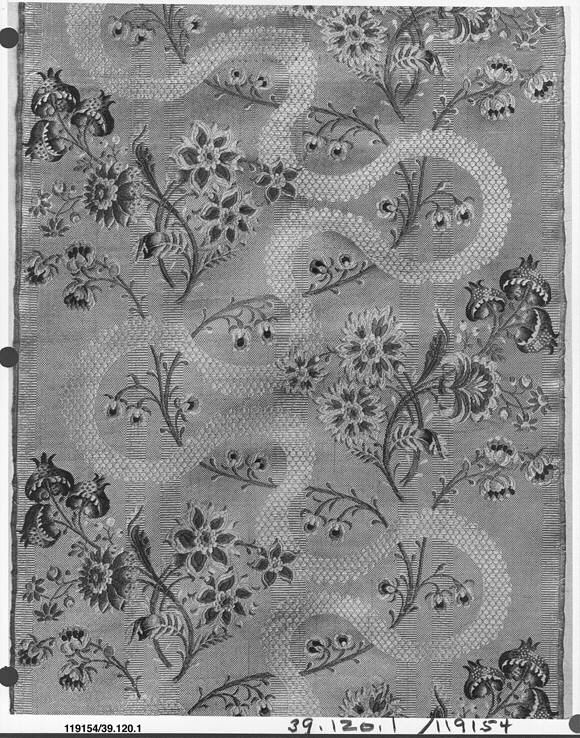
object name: piece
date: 1750-1760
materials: silk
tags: flowers